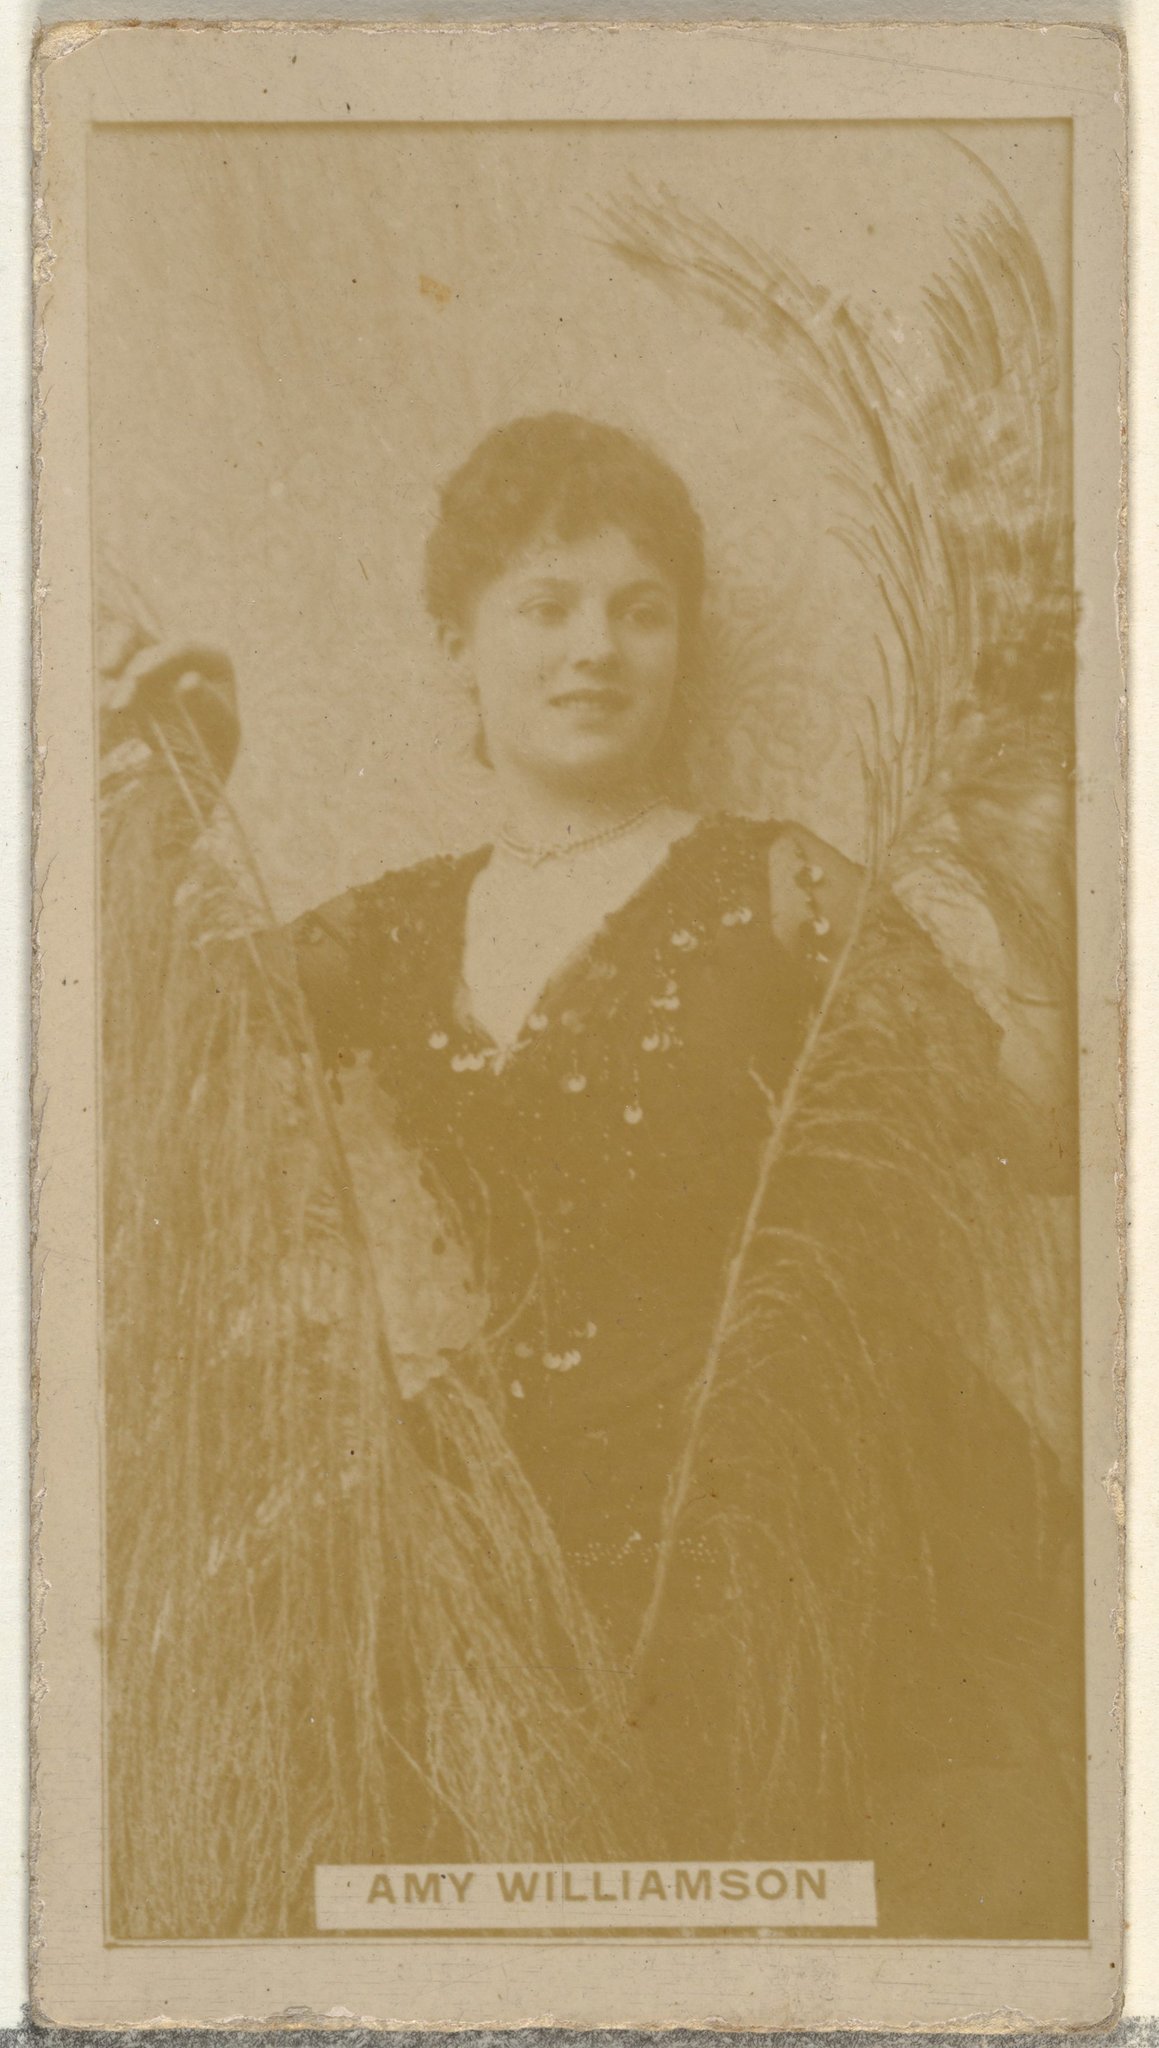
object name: photograph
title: Amy Williamson, from the Actors and Actresses series (N145-8) issued by Duke Sons & Co. to promote Duke Cigarettes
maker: w. duke, sons & co.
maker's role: publisher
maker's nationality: american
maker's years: 1870-1920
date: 1891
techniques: albumen silver print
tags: portraits,women,actresses